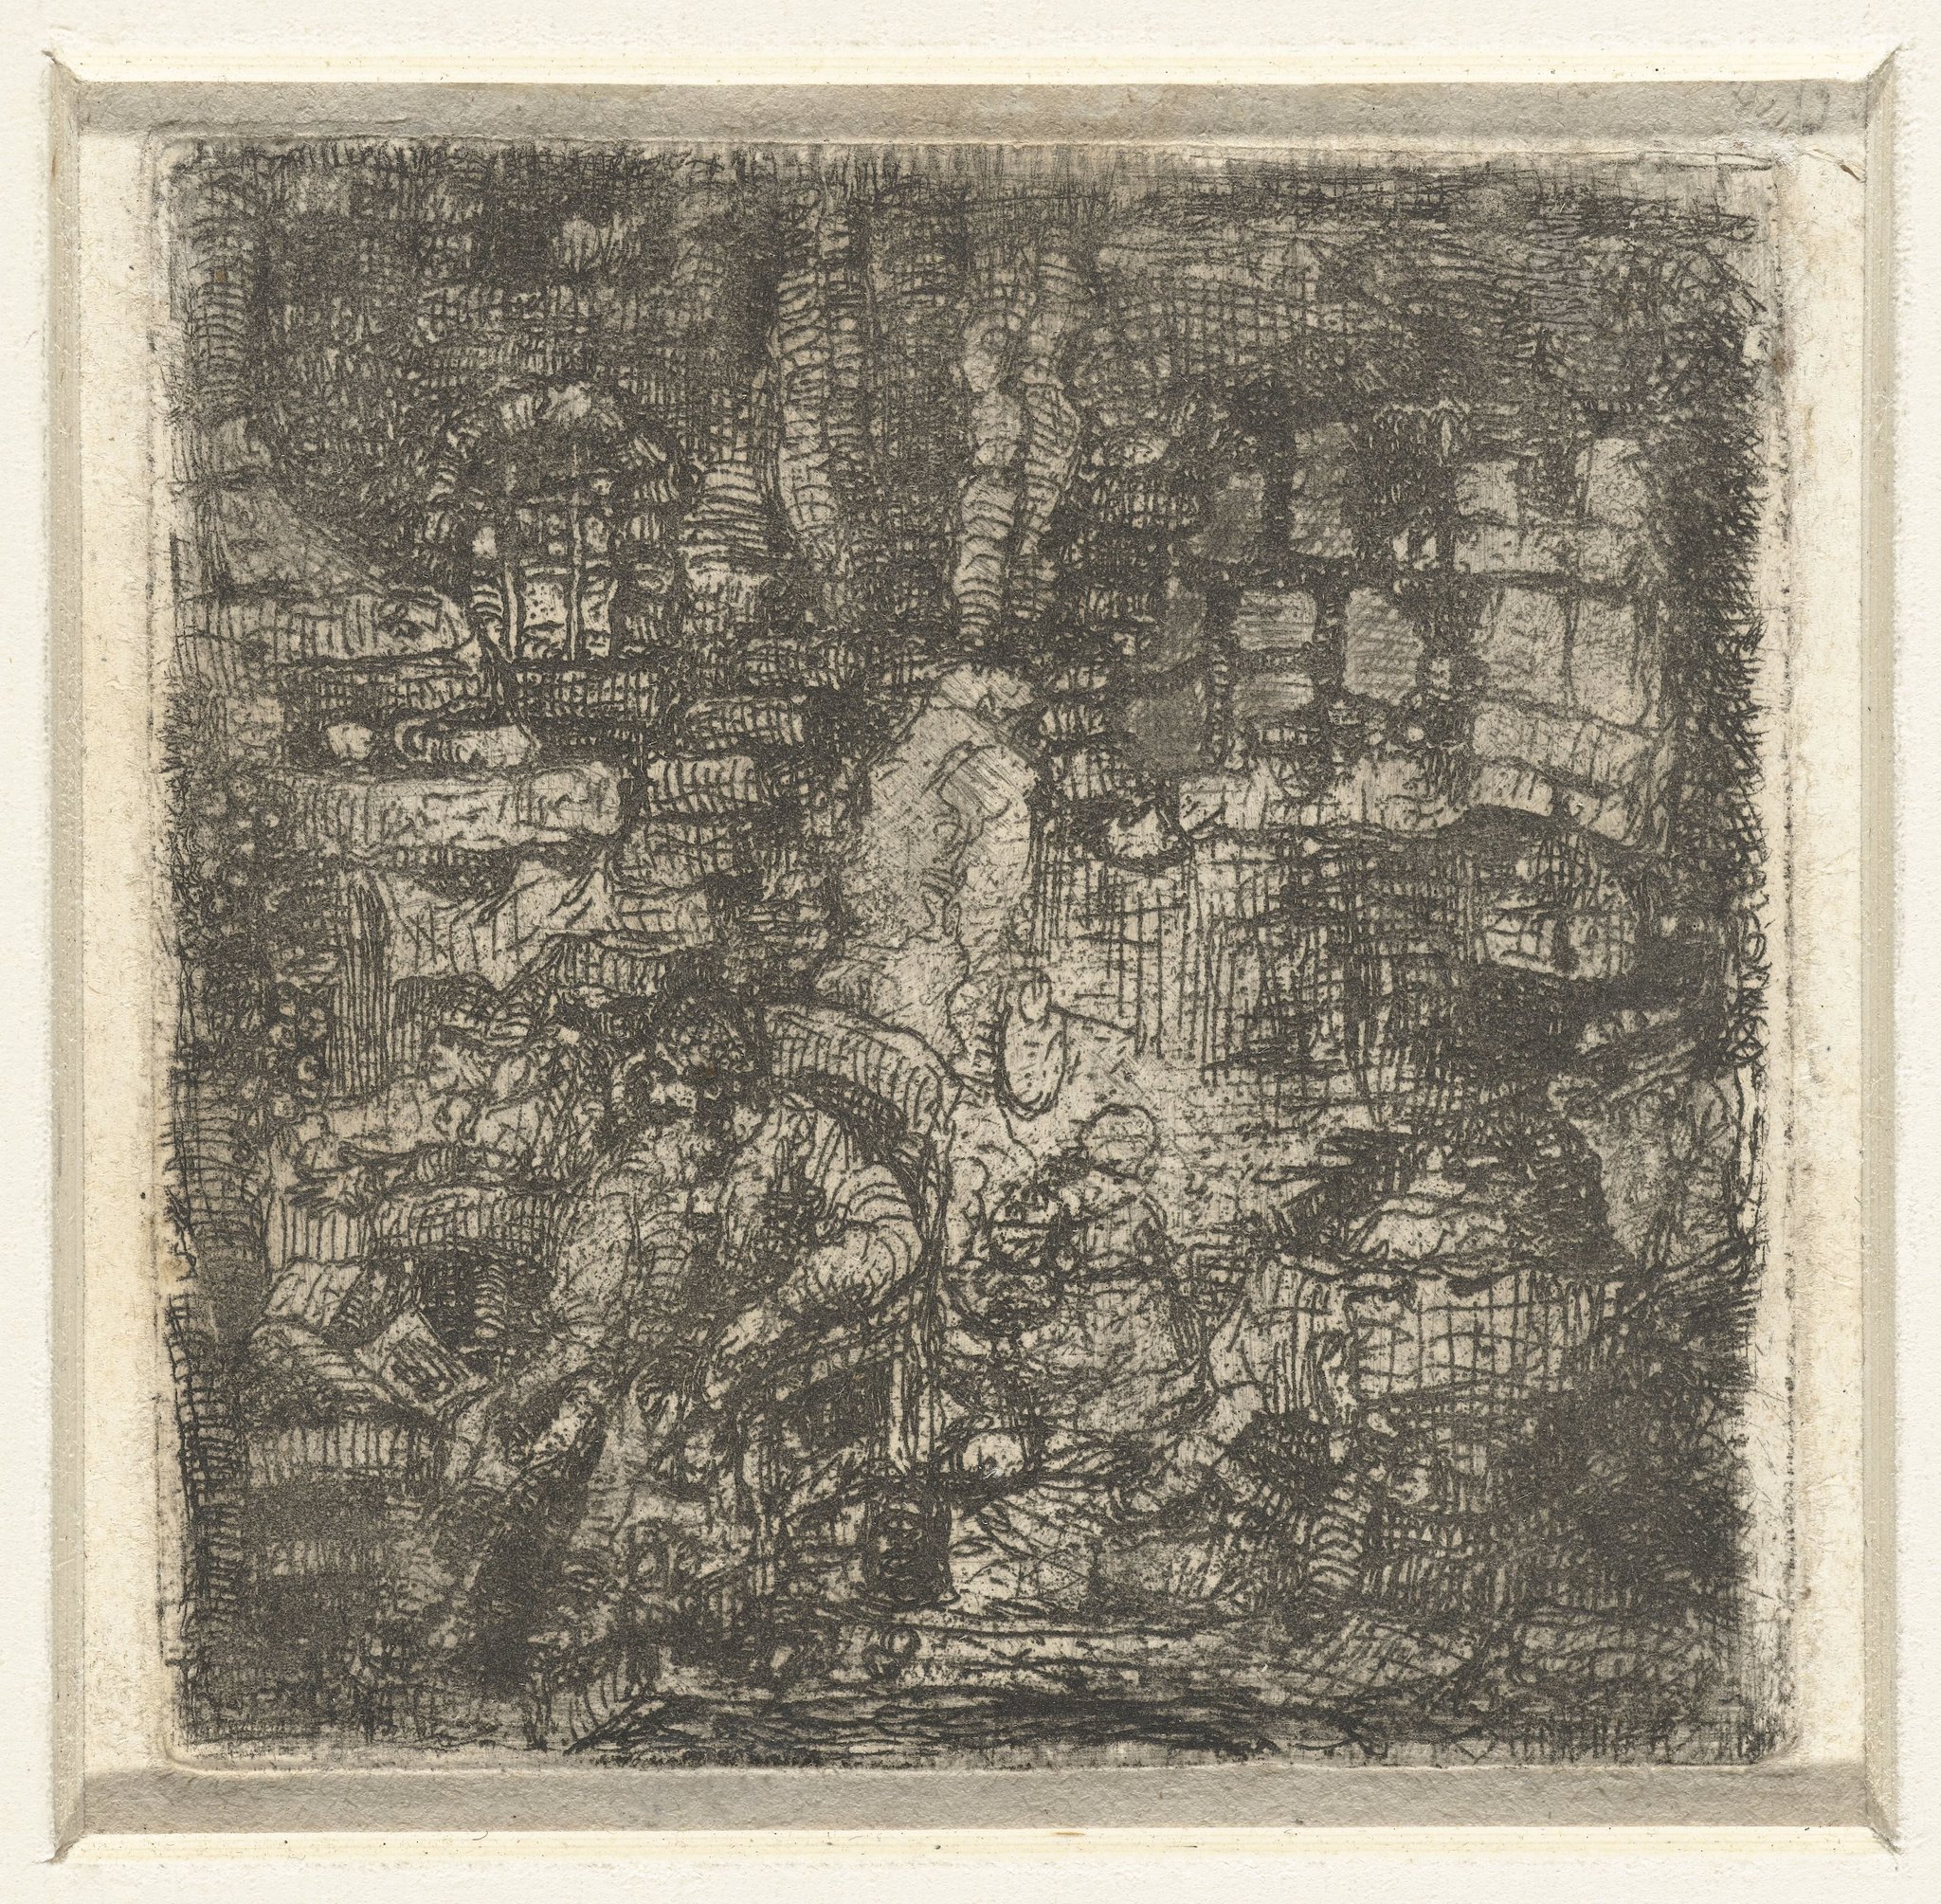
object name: print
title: Vieillard assis près d'un chéminée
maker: rodolphe bresdin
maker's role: draughtsman, print maker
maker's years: 1822-1885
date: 1841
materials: paper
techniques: etching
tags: old man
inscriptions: collector's mark: Lugt 2760, collector's mark: Lugt 2228